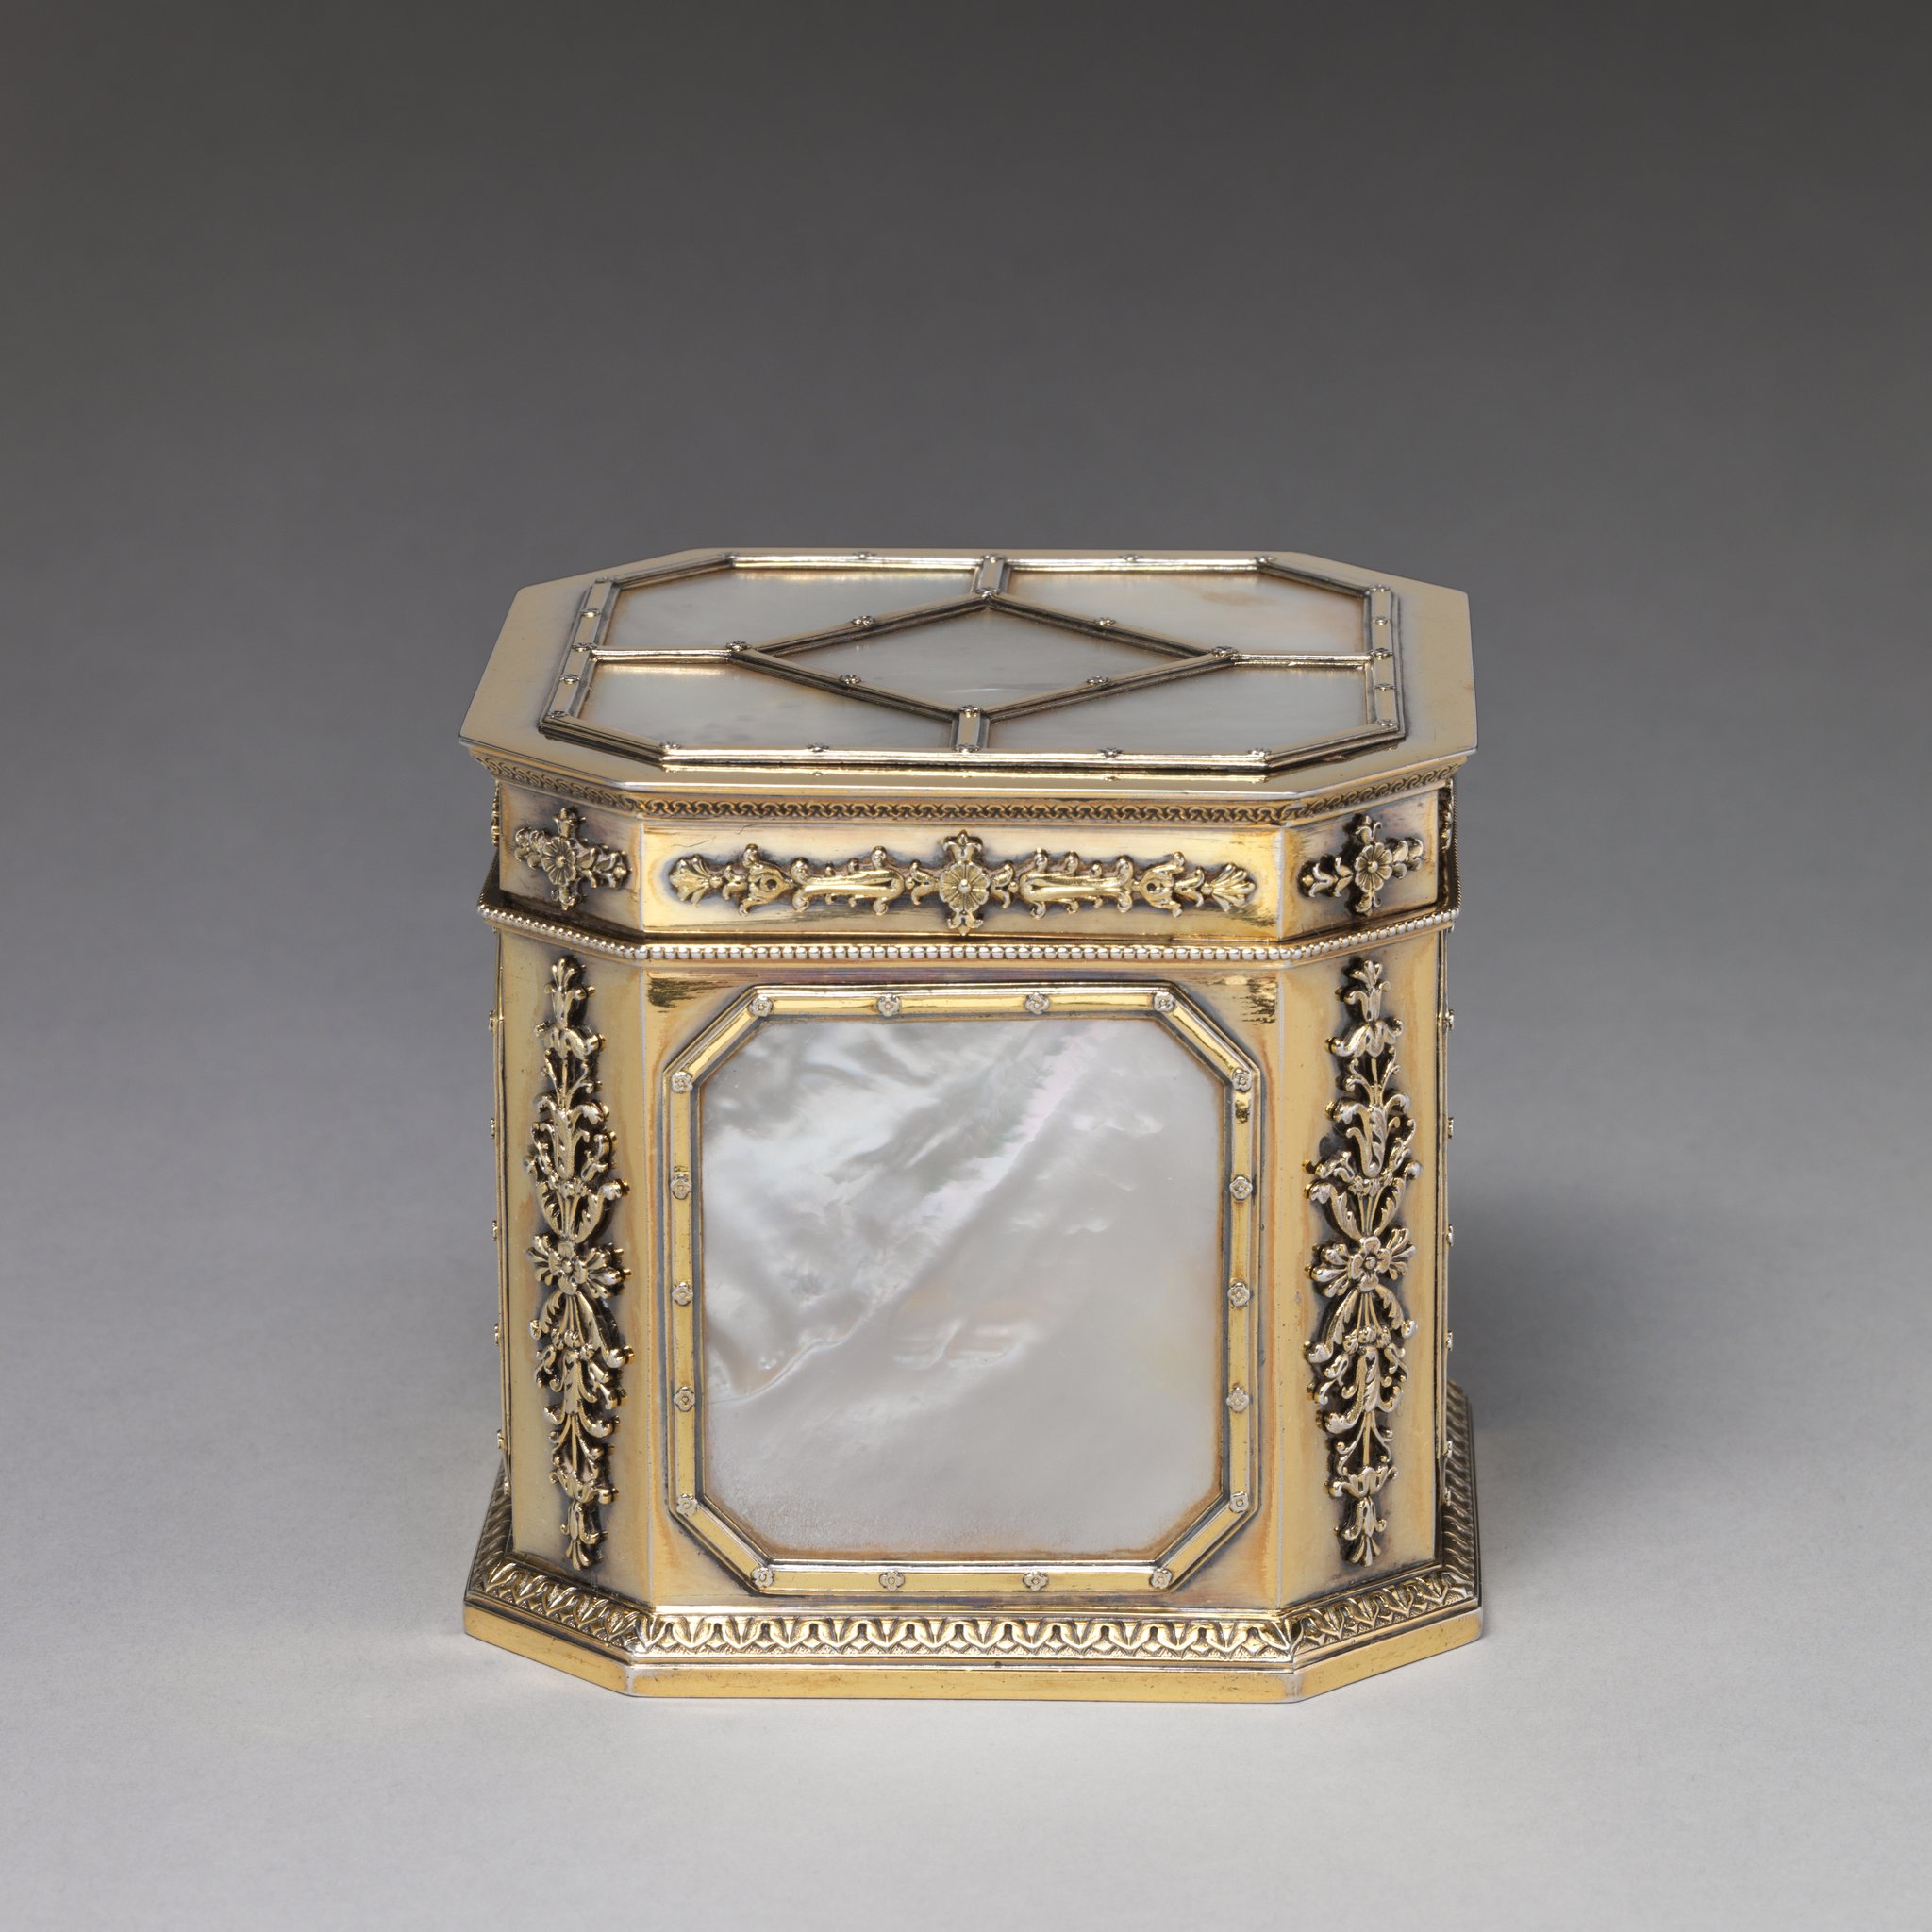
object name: box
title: Medium square box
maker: andré aucoc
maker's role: maker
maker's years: 1825-1925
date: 1887-1911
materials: mother of pearl, silver gilt